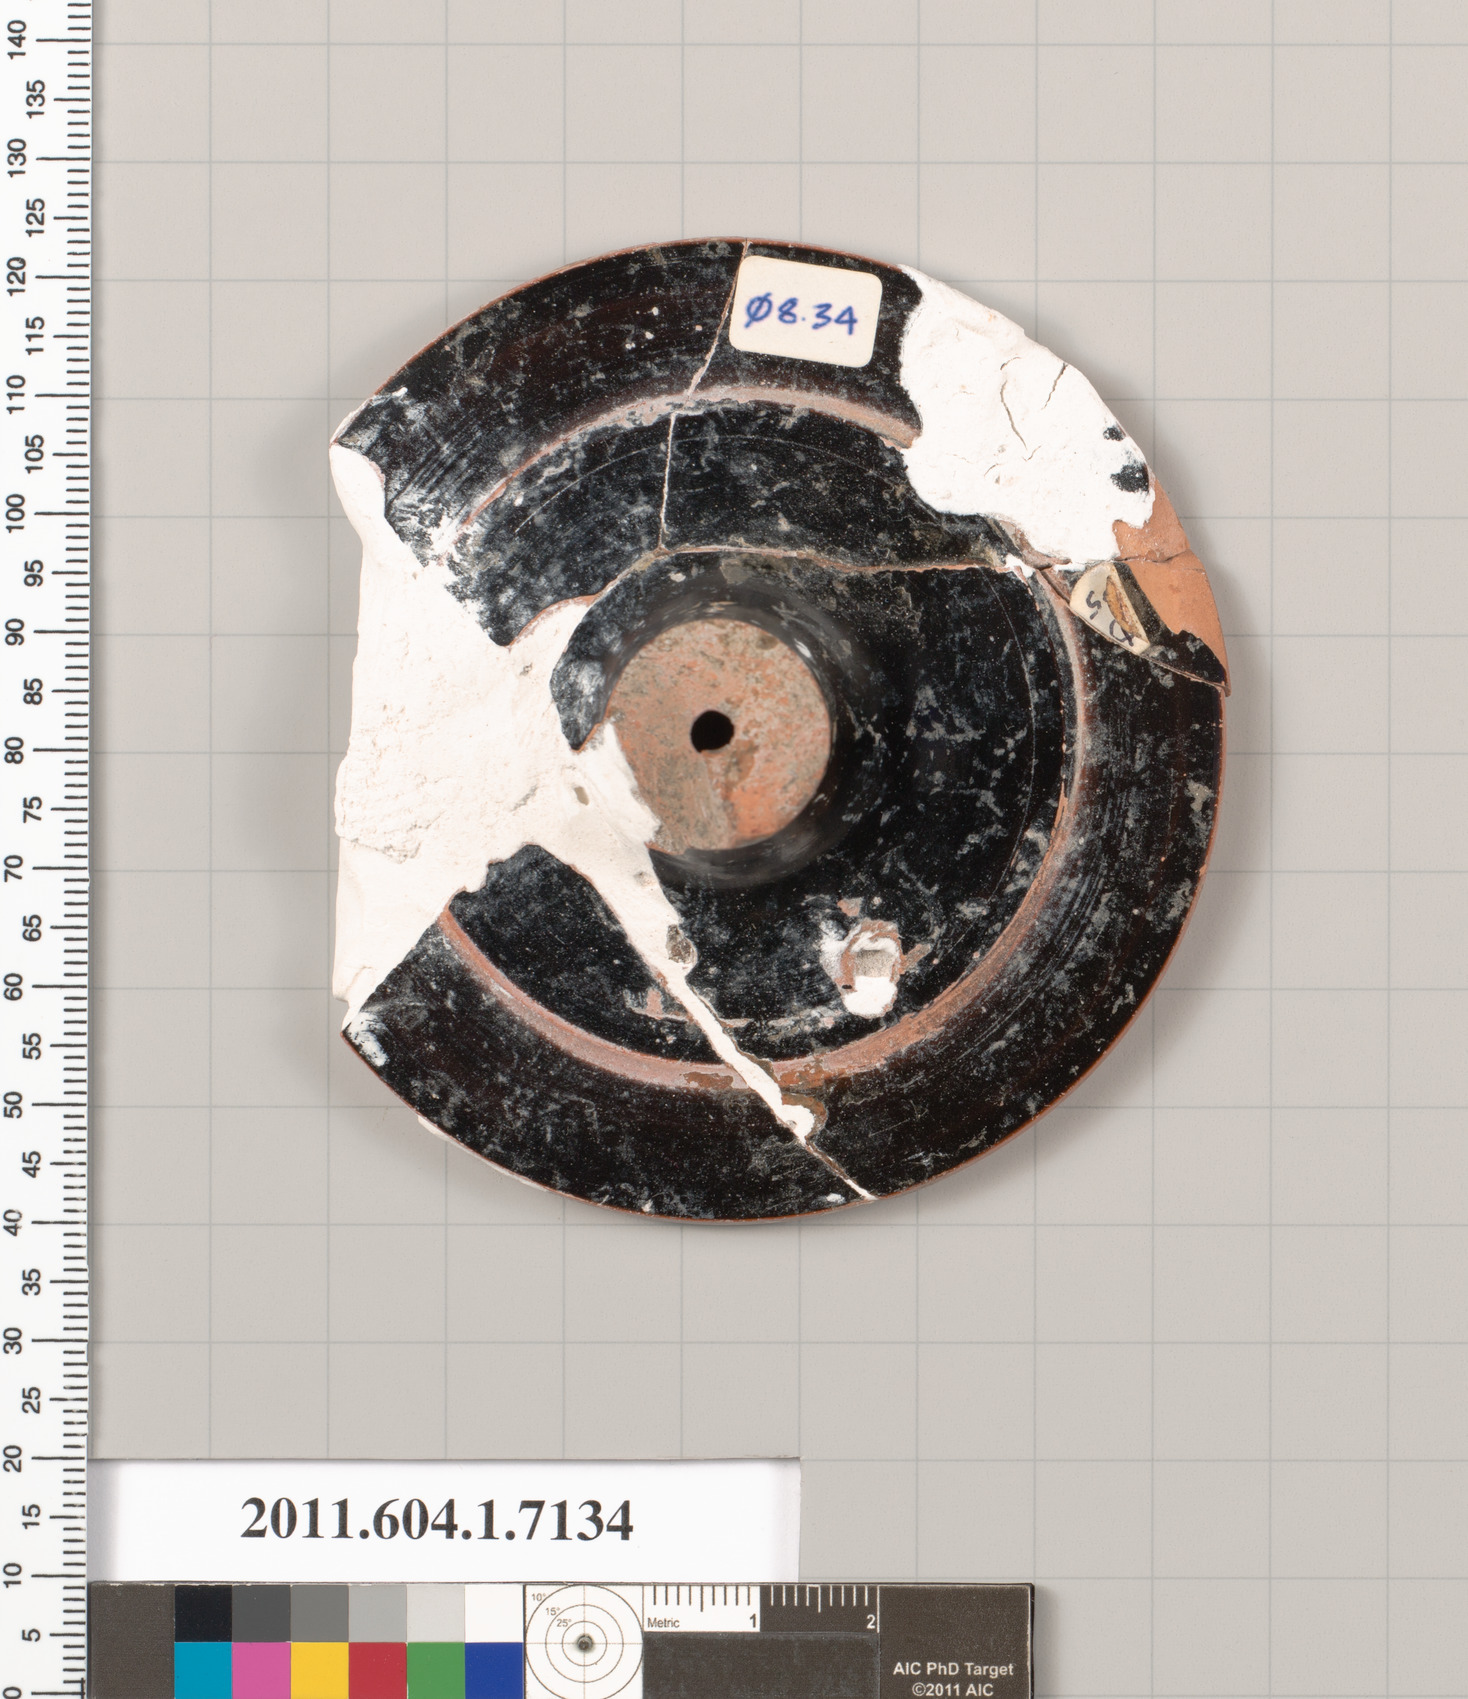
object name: kylix fragment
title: Terracotta fragment of a kylix (drinking cup)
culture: greek, attic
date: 500-480 BCE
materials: terracotta